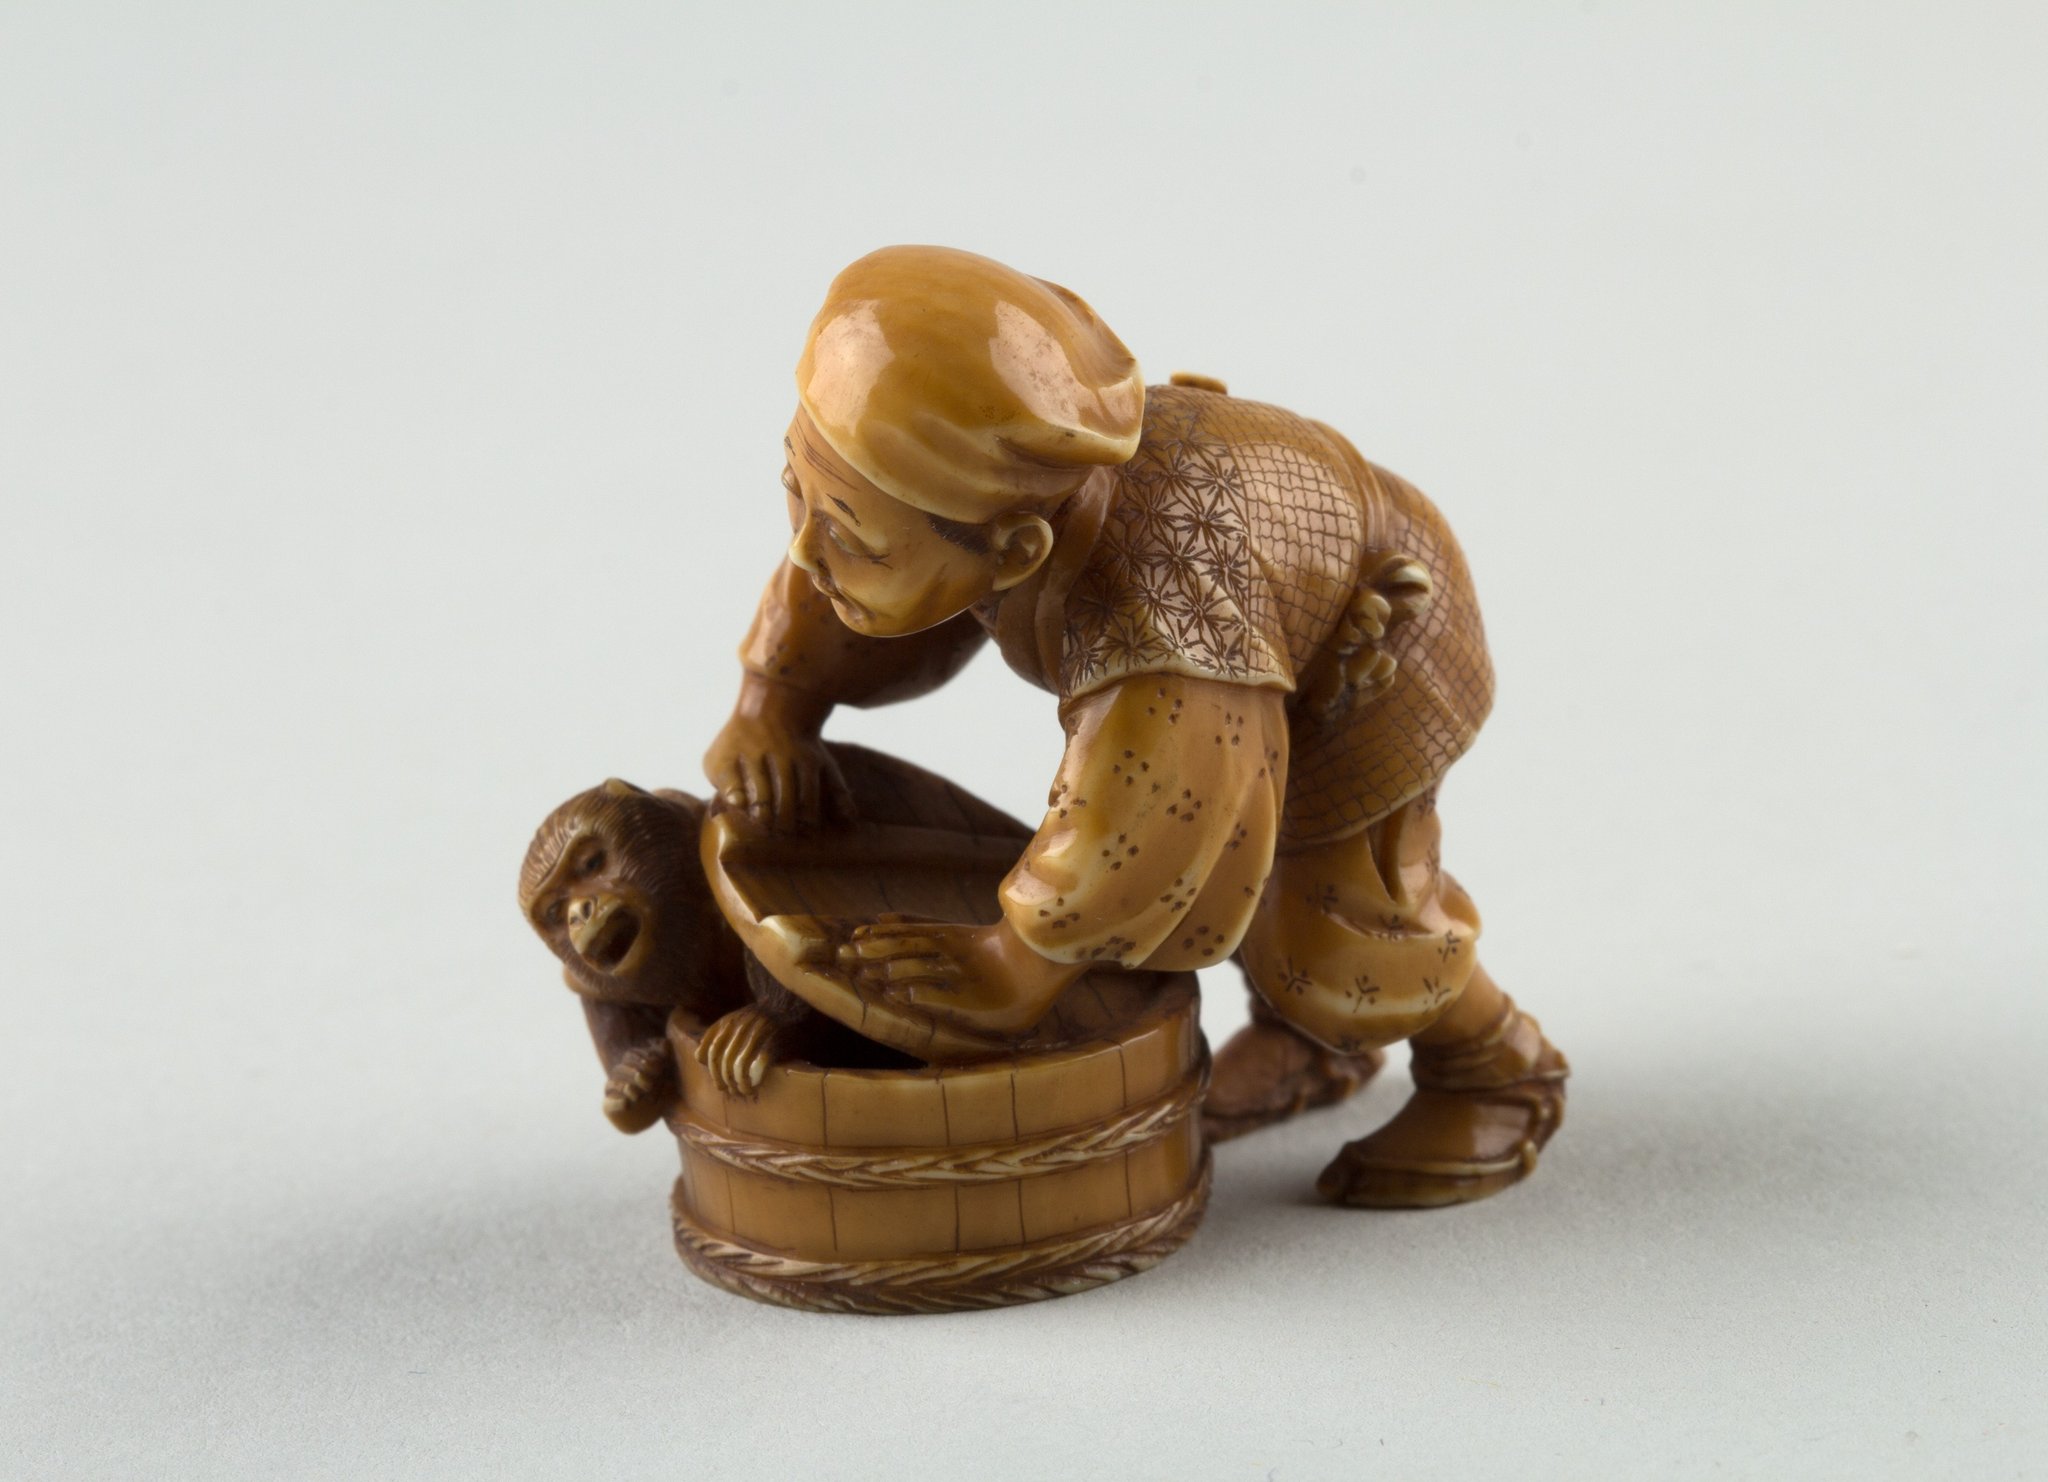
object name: netsuke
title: Netsuke of Man Forcing Monkey into a Basket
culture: japanese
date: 1801-1900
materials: ivory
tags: men,monkeys